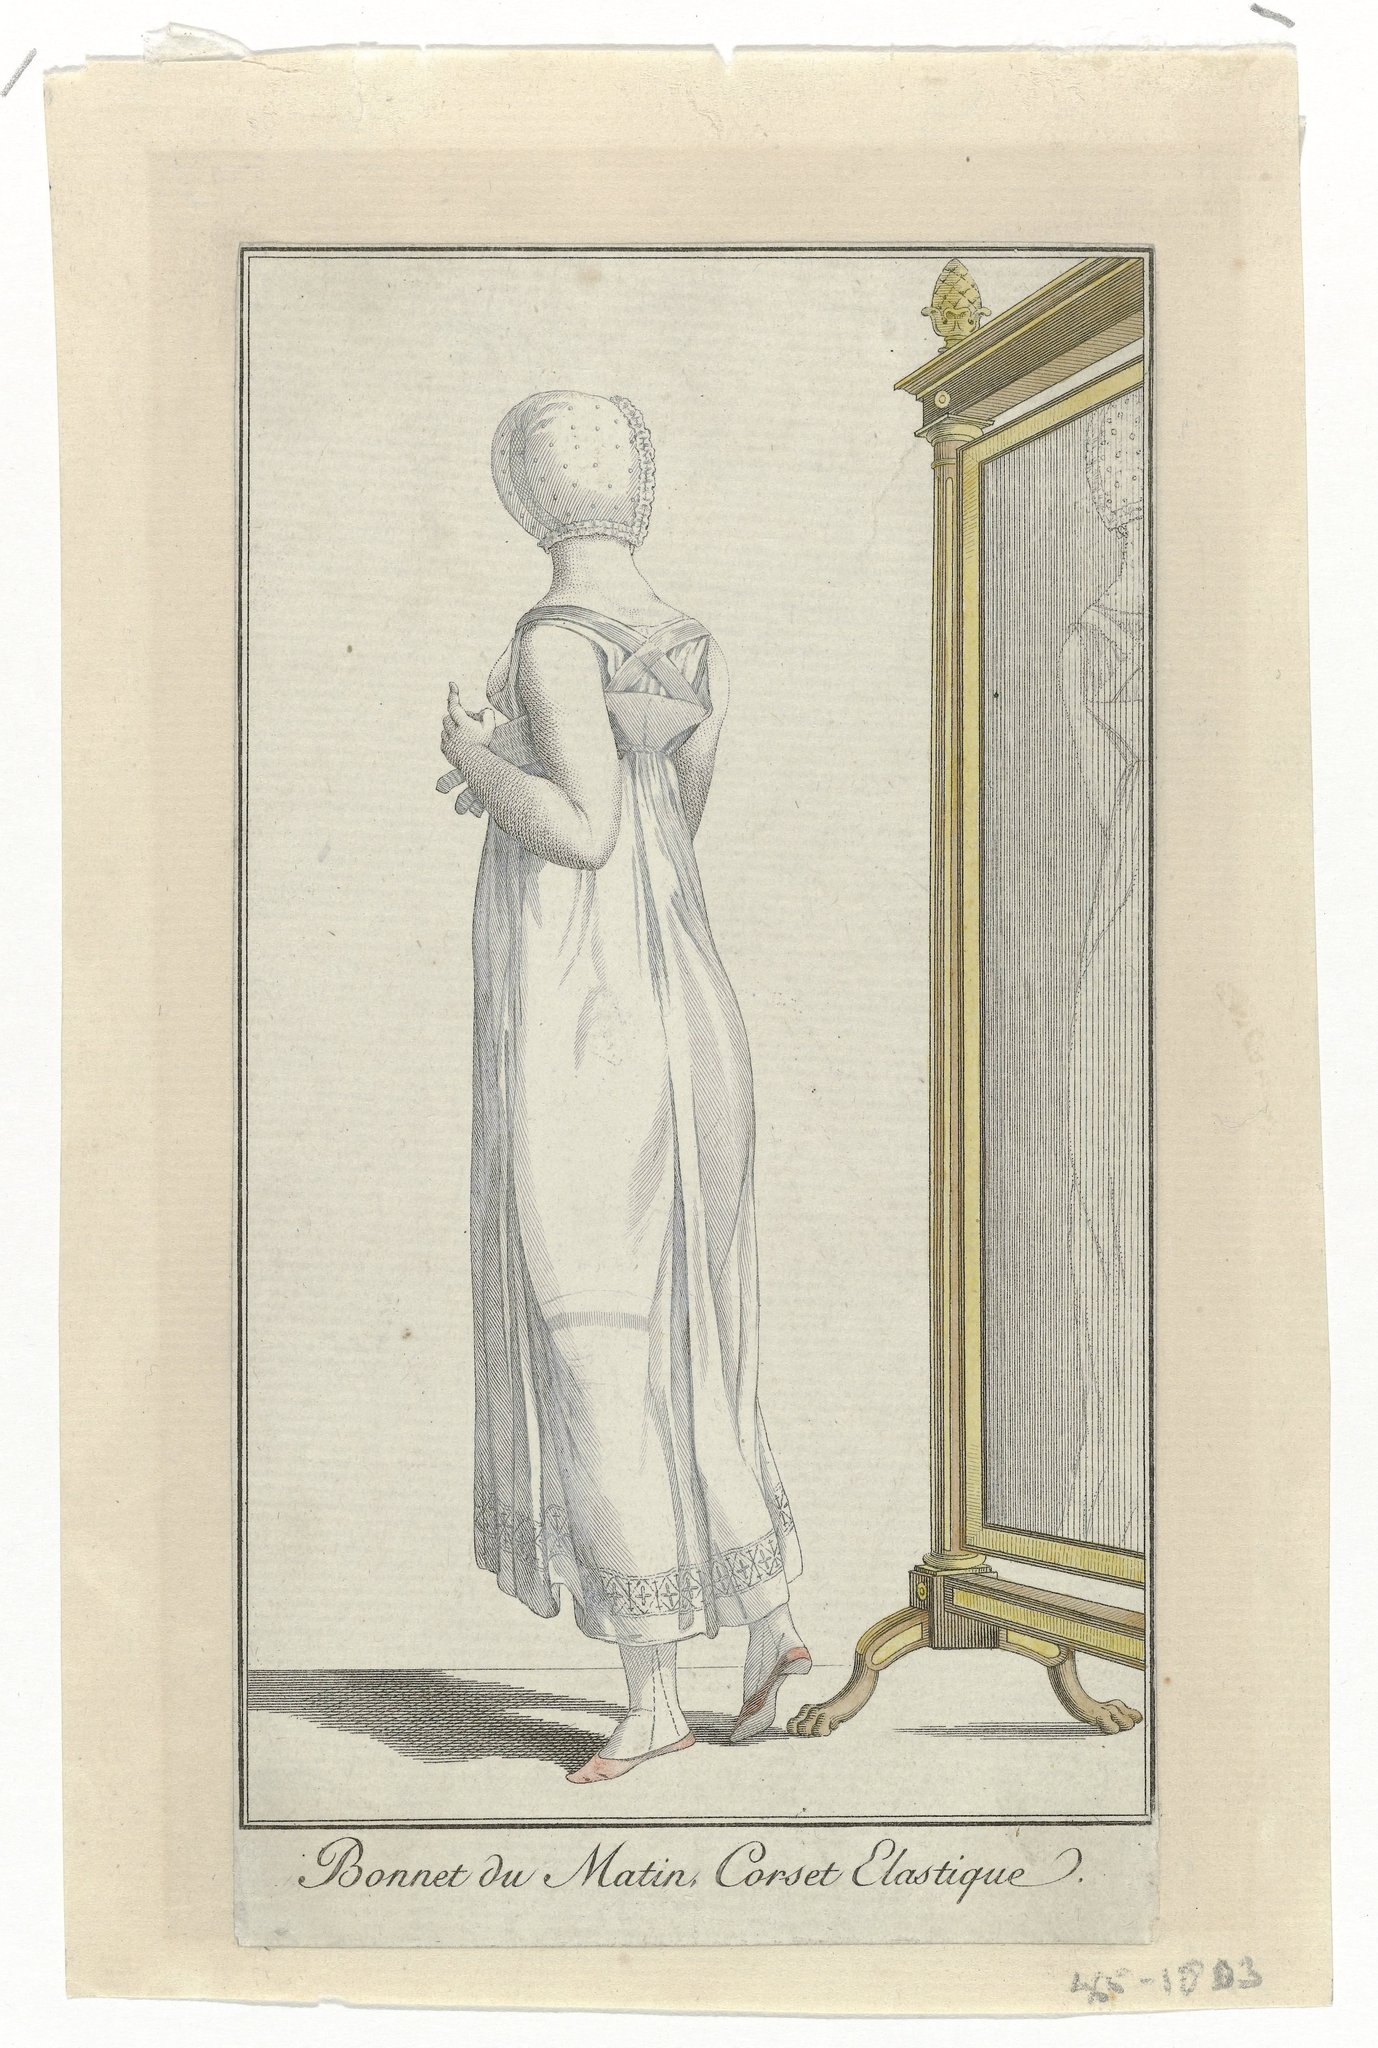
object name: fashion print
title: Morning hat, Elastic corset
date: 1803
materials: paper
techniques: engraving, hand coloring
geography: paris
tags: underclothes for the upper part of the body: corset (+ women's clothes), head-gear: morning cap (+ women's clothes), reflection (in a mirror) - aa - (for) women (+ back view), underclothes for the whole body (chemise) (+ women's clothes), fashion plates, shoes, sandals (+ women's clothes), stockings, socks (+ women's clothes)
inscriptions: caption: ‘Bonnet du Matin. Corset Elastique.’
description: Vrouw, op de rug gezien, staand voor een passpiegel. Zij draagt een elastische korset op een 'chemise'. Op het hoofd een gestippelde muts voor in de ochtend. Kousen en platte schoenen met puntige neuzen. De prent maakt deel uit van het modetijdschrift Journal des Dames et des Modes, uitgegeven door Pierre de la Mésangère, Parijs, 1797-1839.